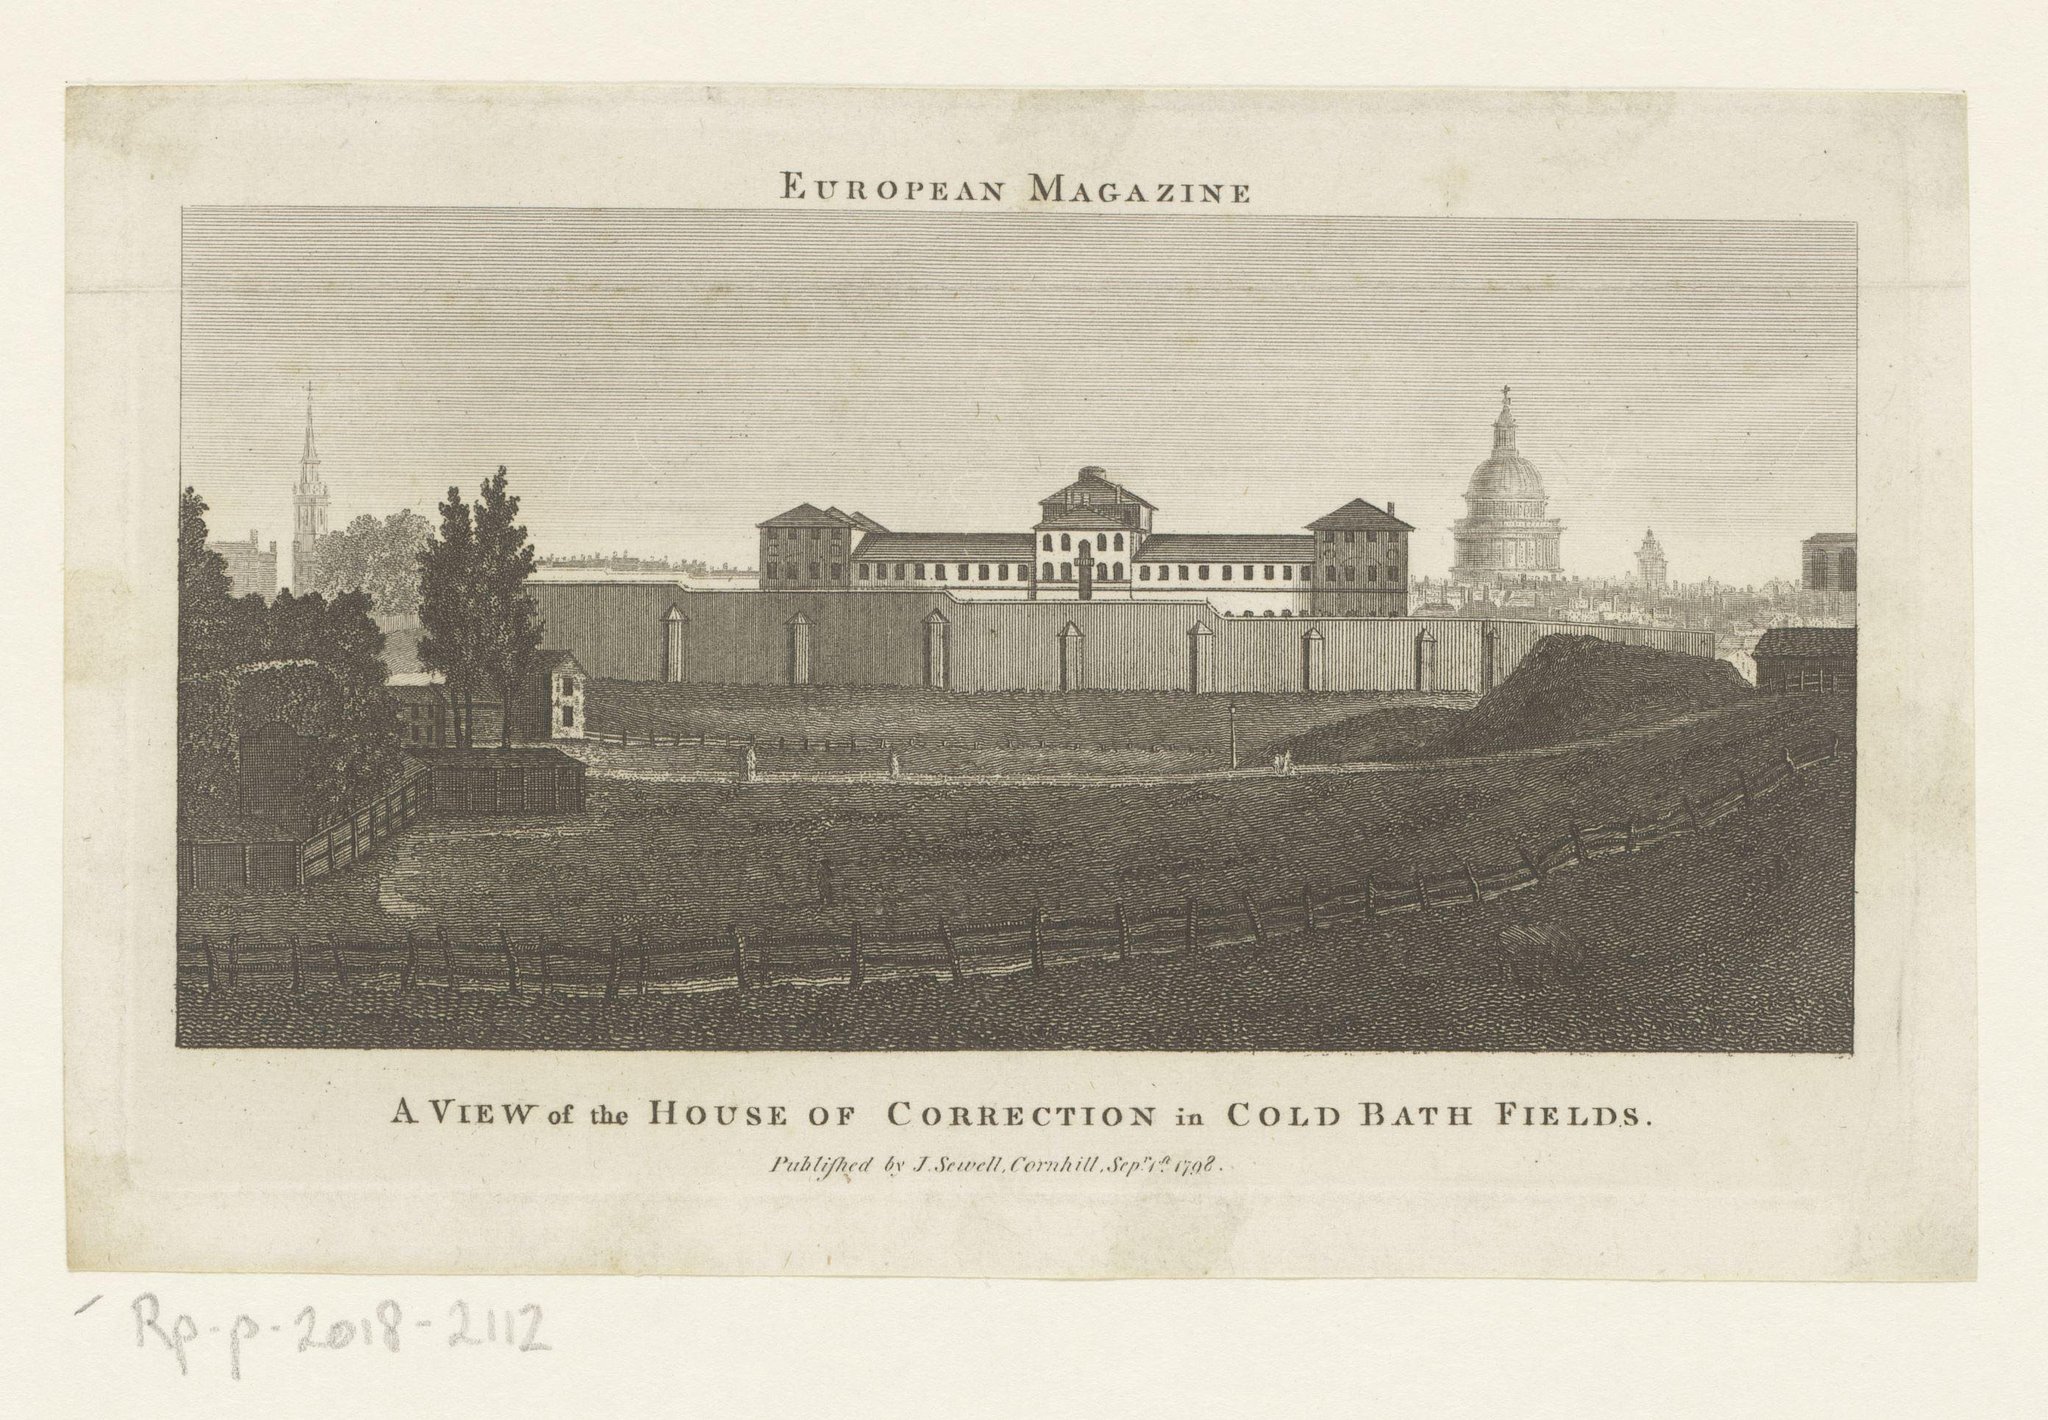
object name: print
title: Gezicht op de Coldbath Fields gevangenis, te Londen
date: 1798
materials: paper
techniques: etching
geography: london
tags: prison, jail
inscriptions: collector's mark: Lugt 2228